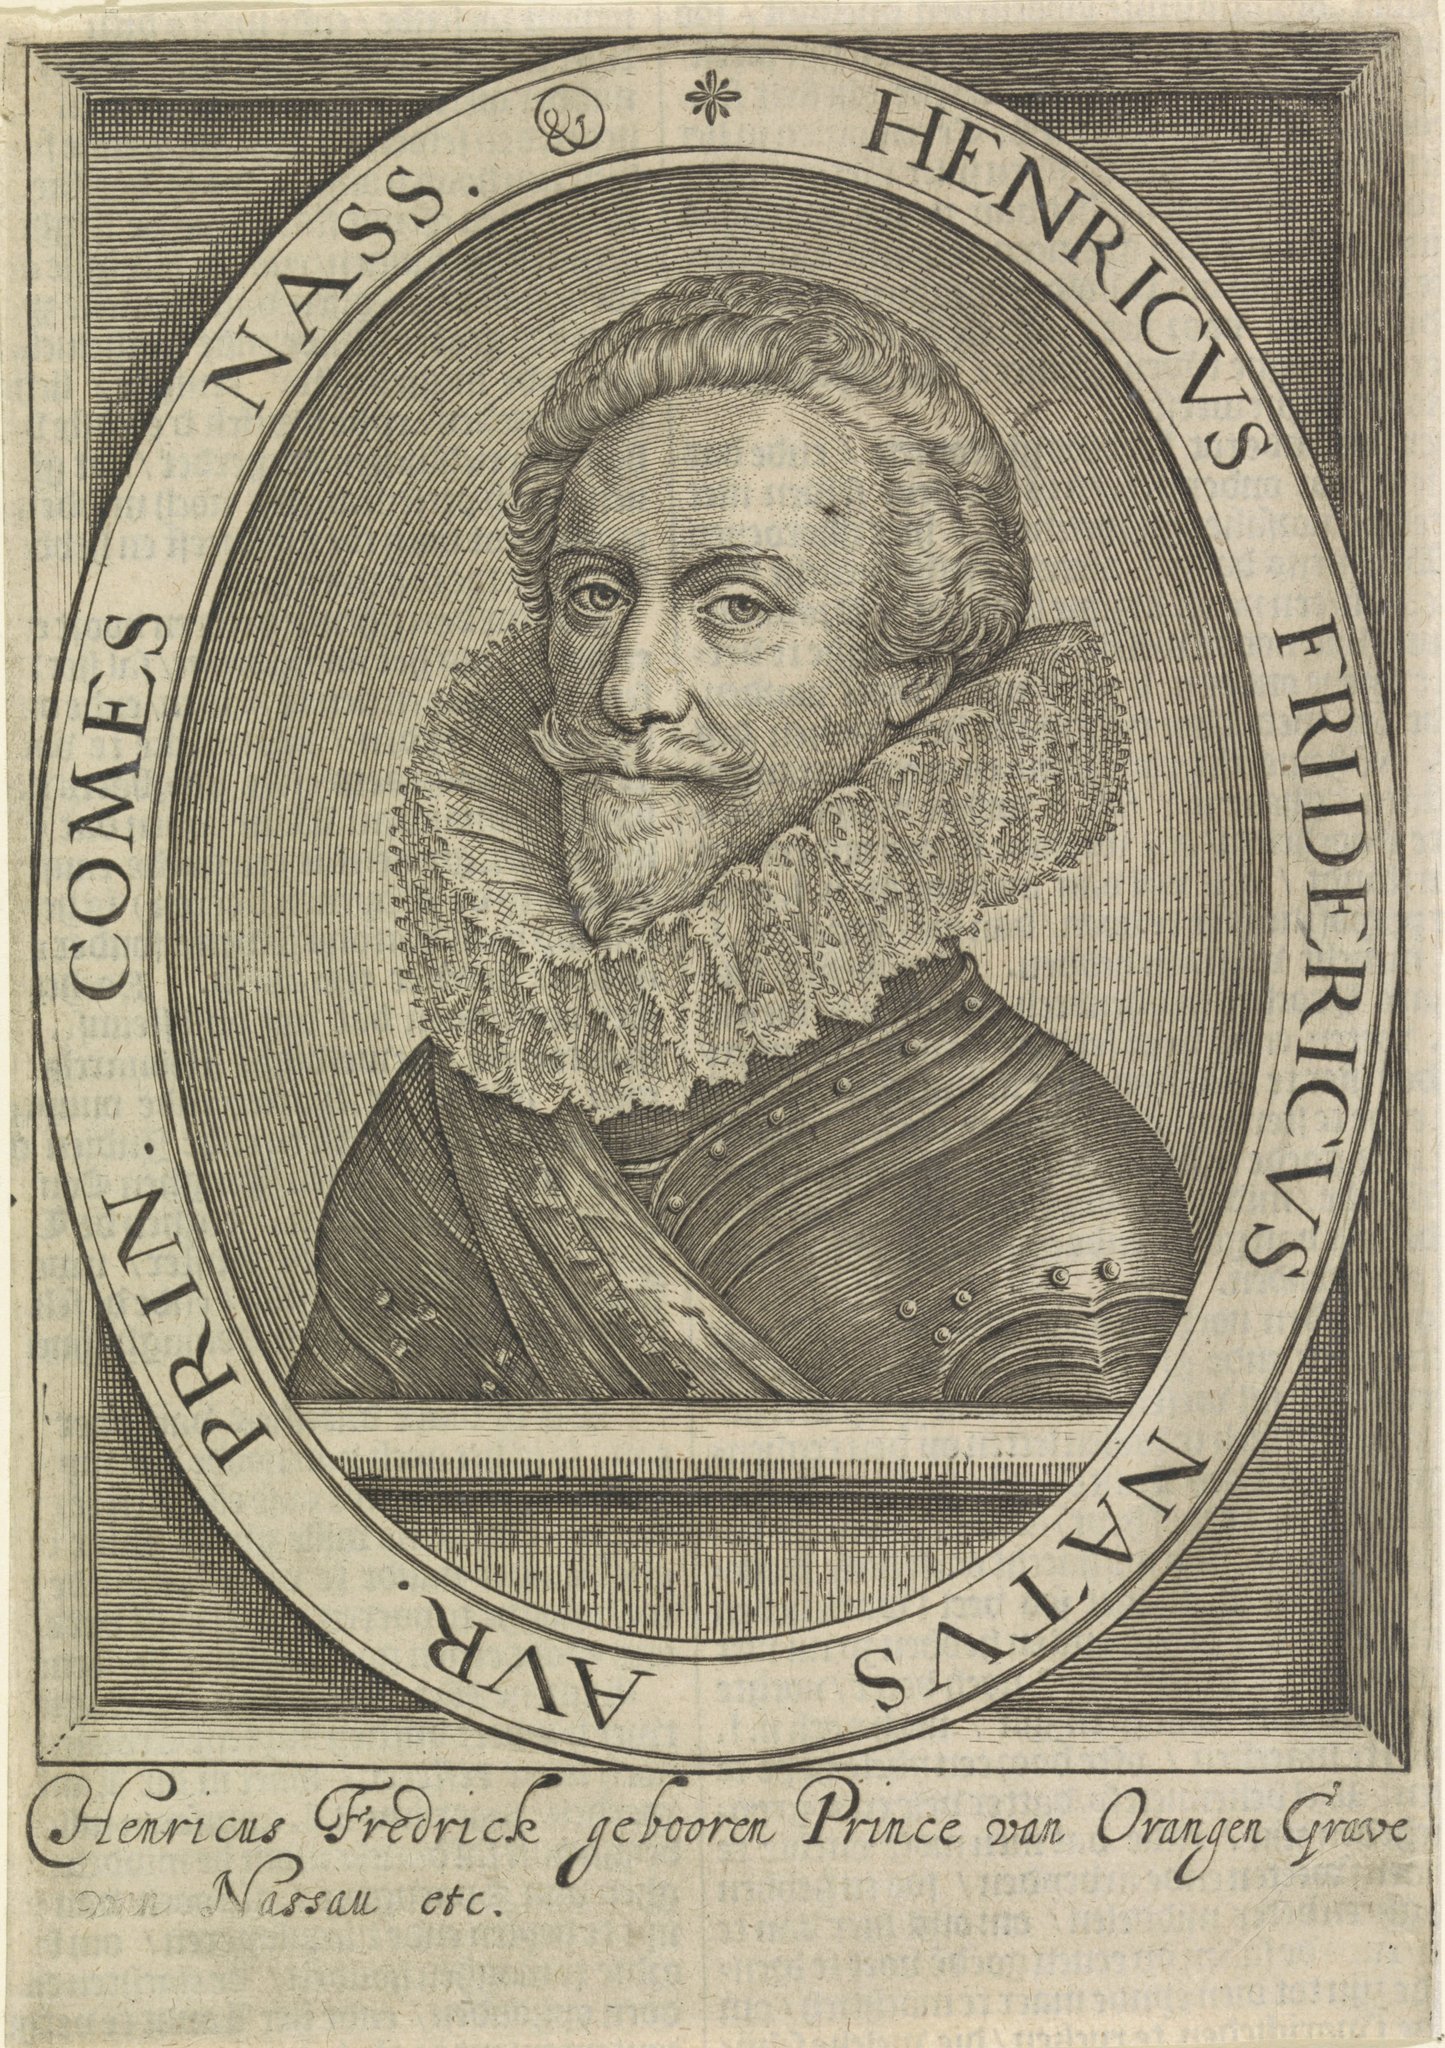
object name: book illustration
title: Portret van Frederik Hendrik, prins van Oranje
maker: Anonymous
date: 1600-1699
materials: paper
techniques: engraving, letterpress printing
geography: low countries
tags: delft, the hague, frederick henry (prince of orange)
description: De hier vermelde titel verwijst naar de hoogst verkregen titel van de geportretteerde, niet per se naar de titel die de geportretteerde op deze voorstelling draagt.